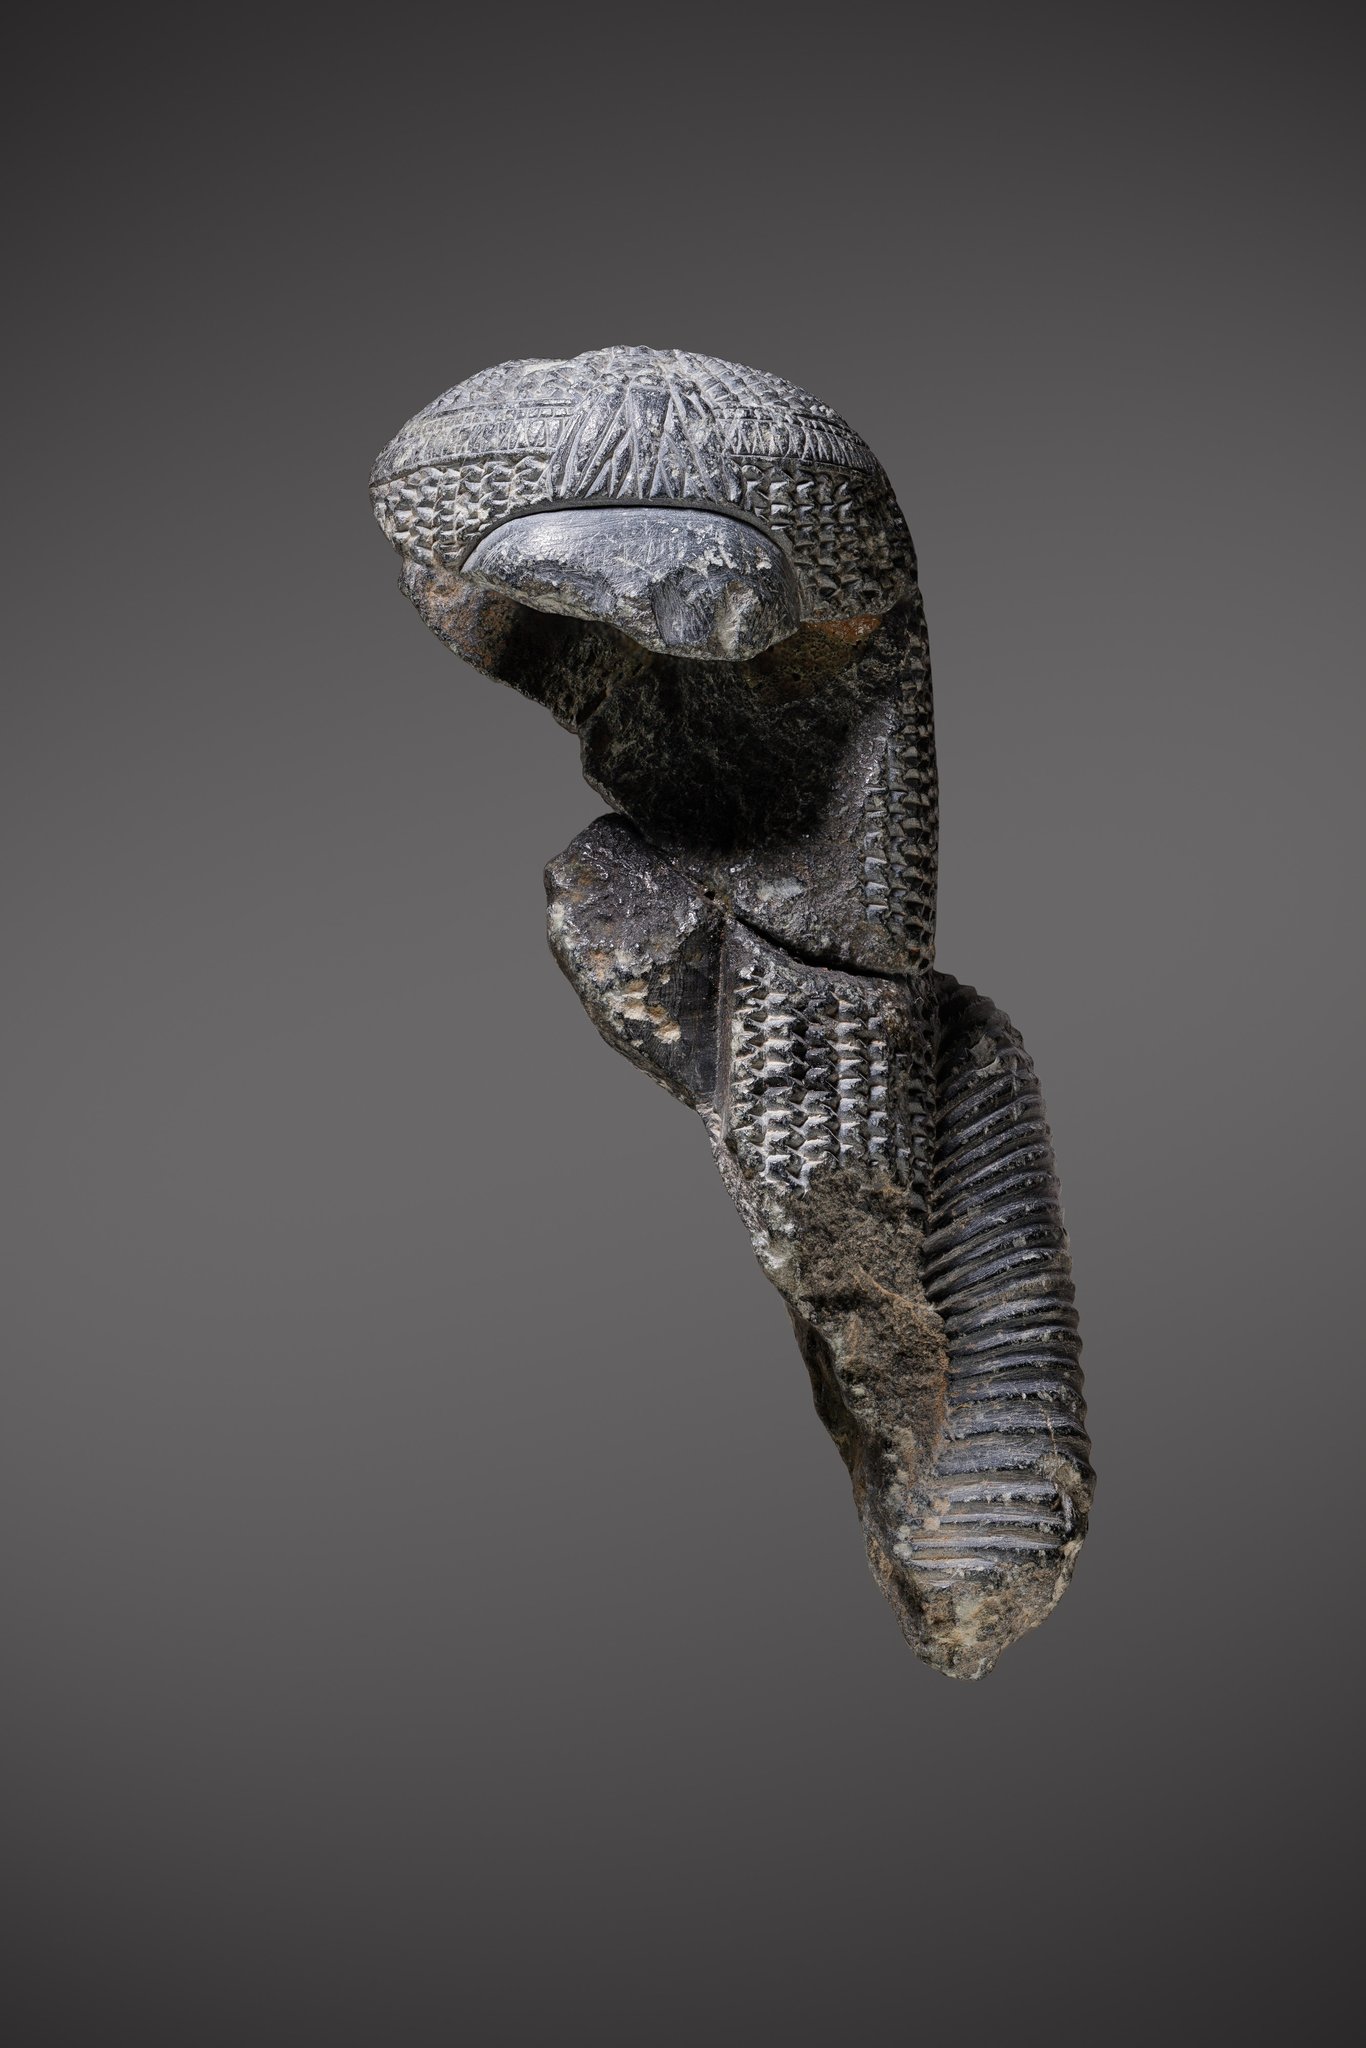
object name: statuette fragment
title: Statuette fragments, possibly depicting Ahmose-Nefertari posthumously based on probable findspot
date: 1400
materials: stone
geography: egypt